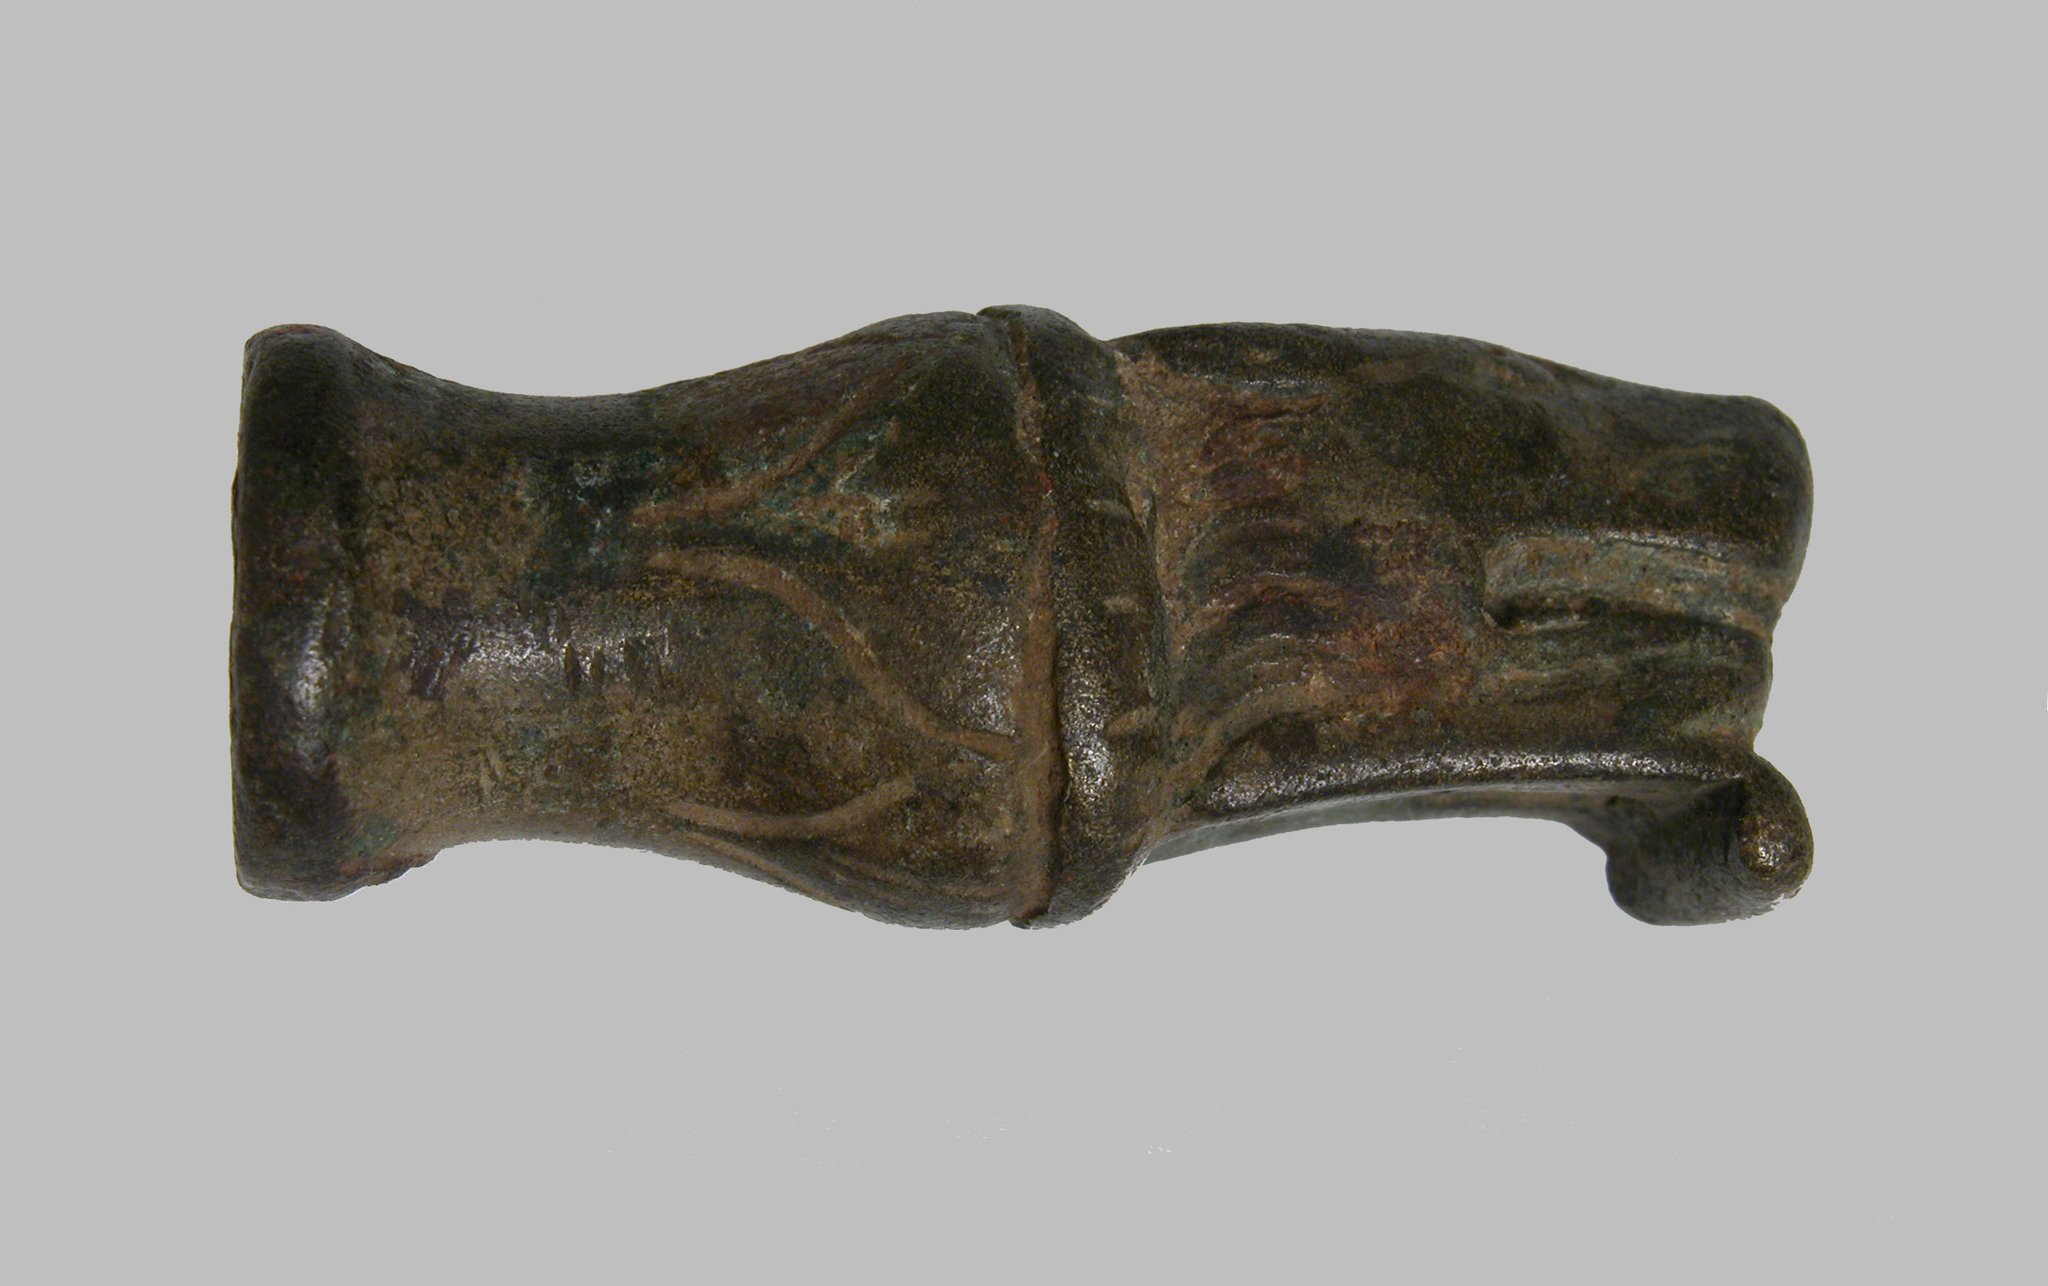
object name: key handle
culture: roman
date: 1-700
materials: copper alloy